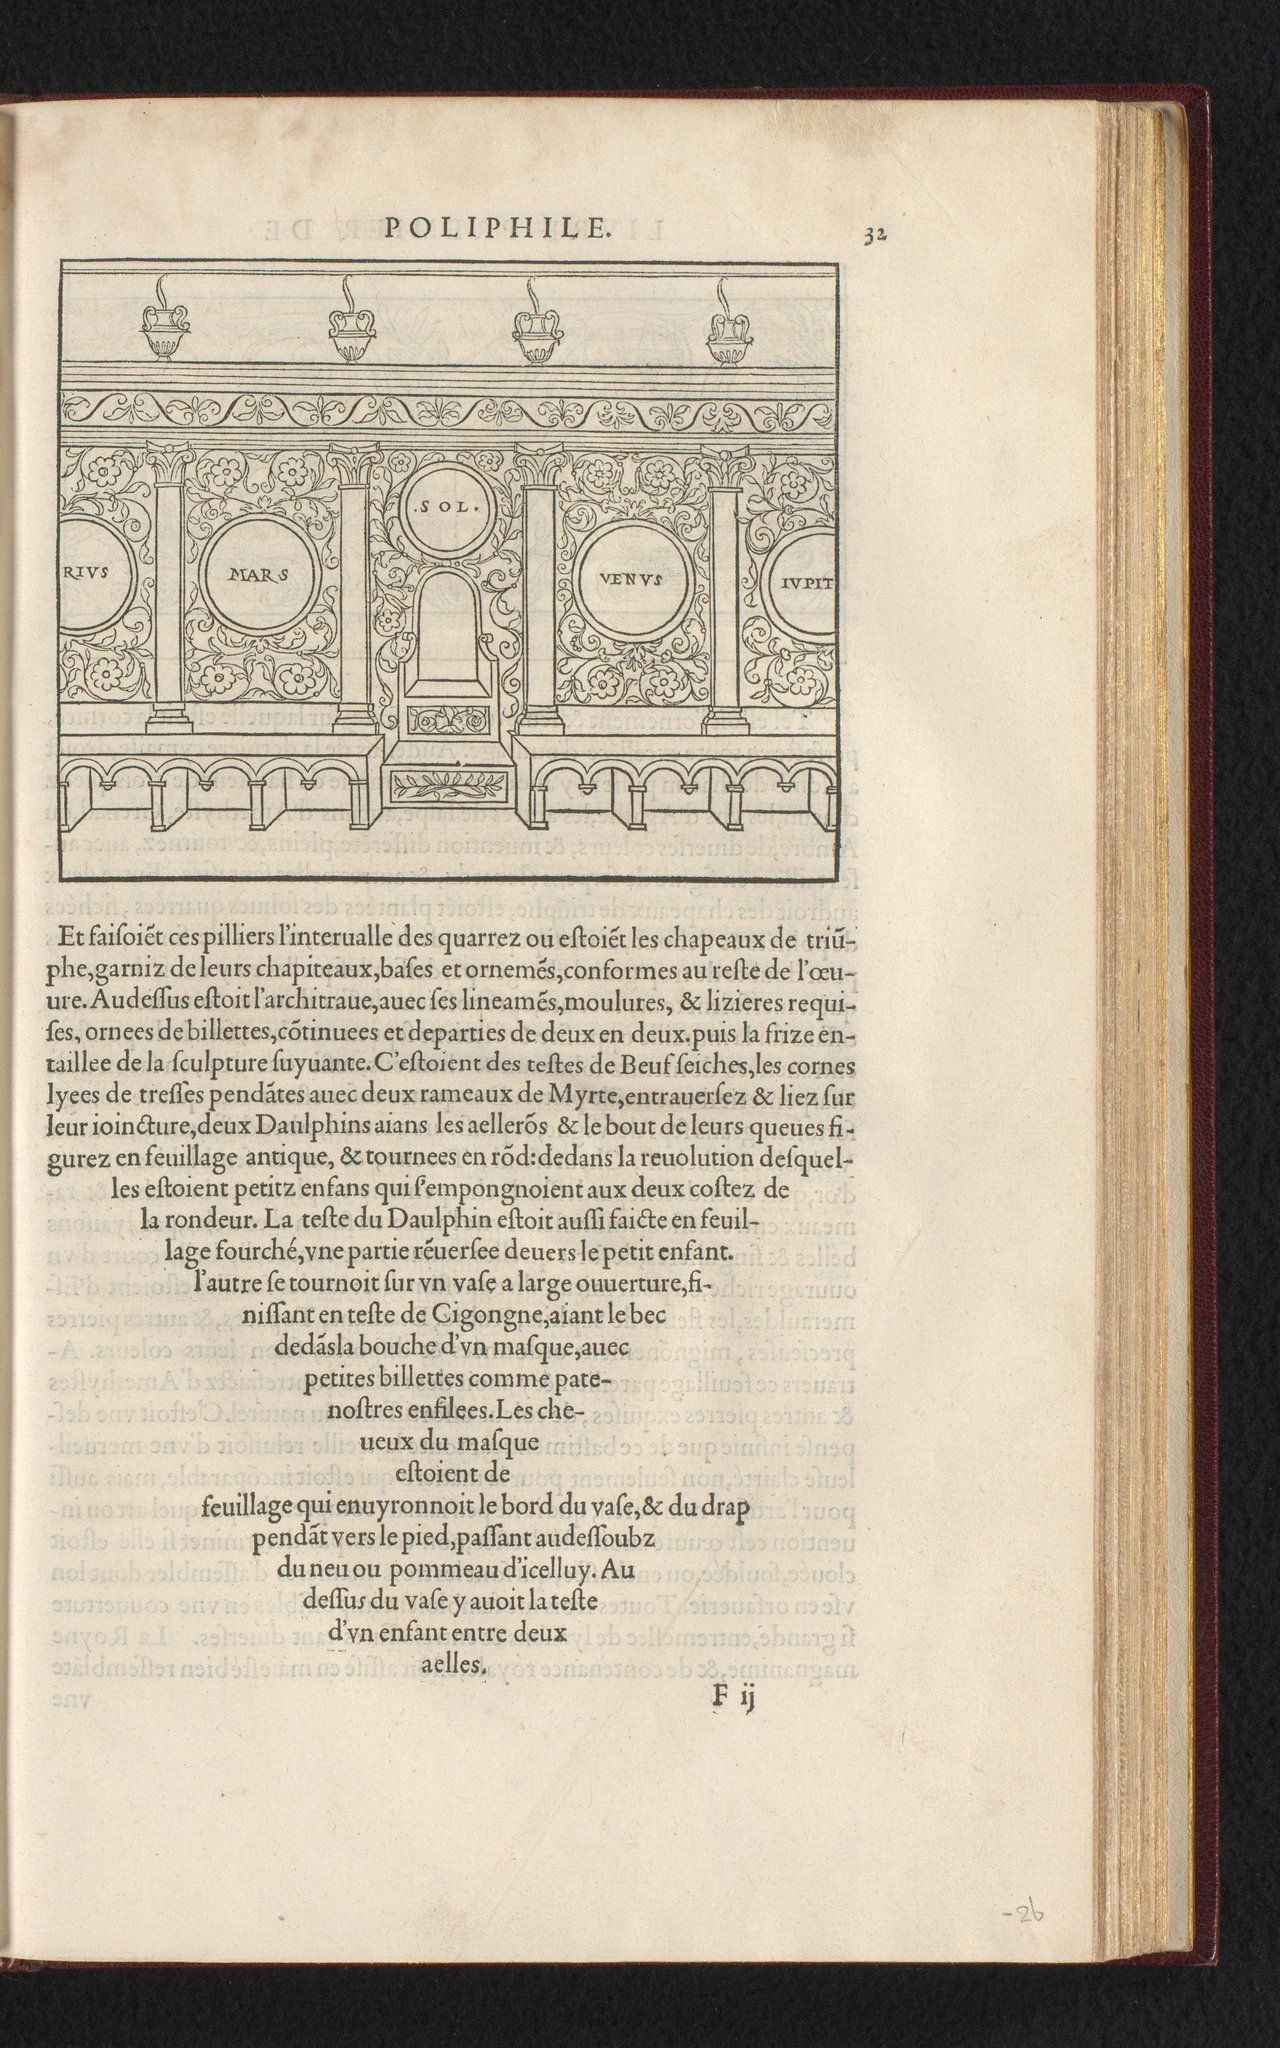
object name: book illustration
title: Gedecoreerde wand met de namen van hemellichamen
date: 1546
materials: paper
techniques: letterpress printing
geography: paris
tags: (scenes from) specific works of literature: colonna, hypnerotomachia poliphili, allegorical representation of the heavens (celestial bodies), wall-covering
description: Prent uit: Colonna, Francesco. Hypnerotomachie ou discours du songe de Poliphile, deduisant comme amour le combat a l'occasion de Polia. Parijs: Jacques Kerver, 1546, recto fol. 32.